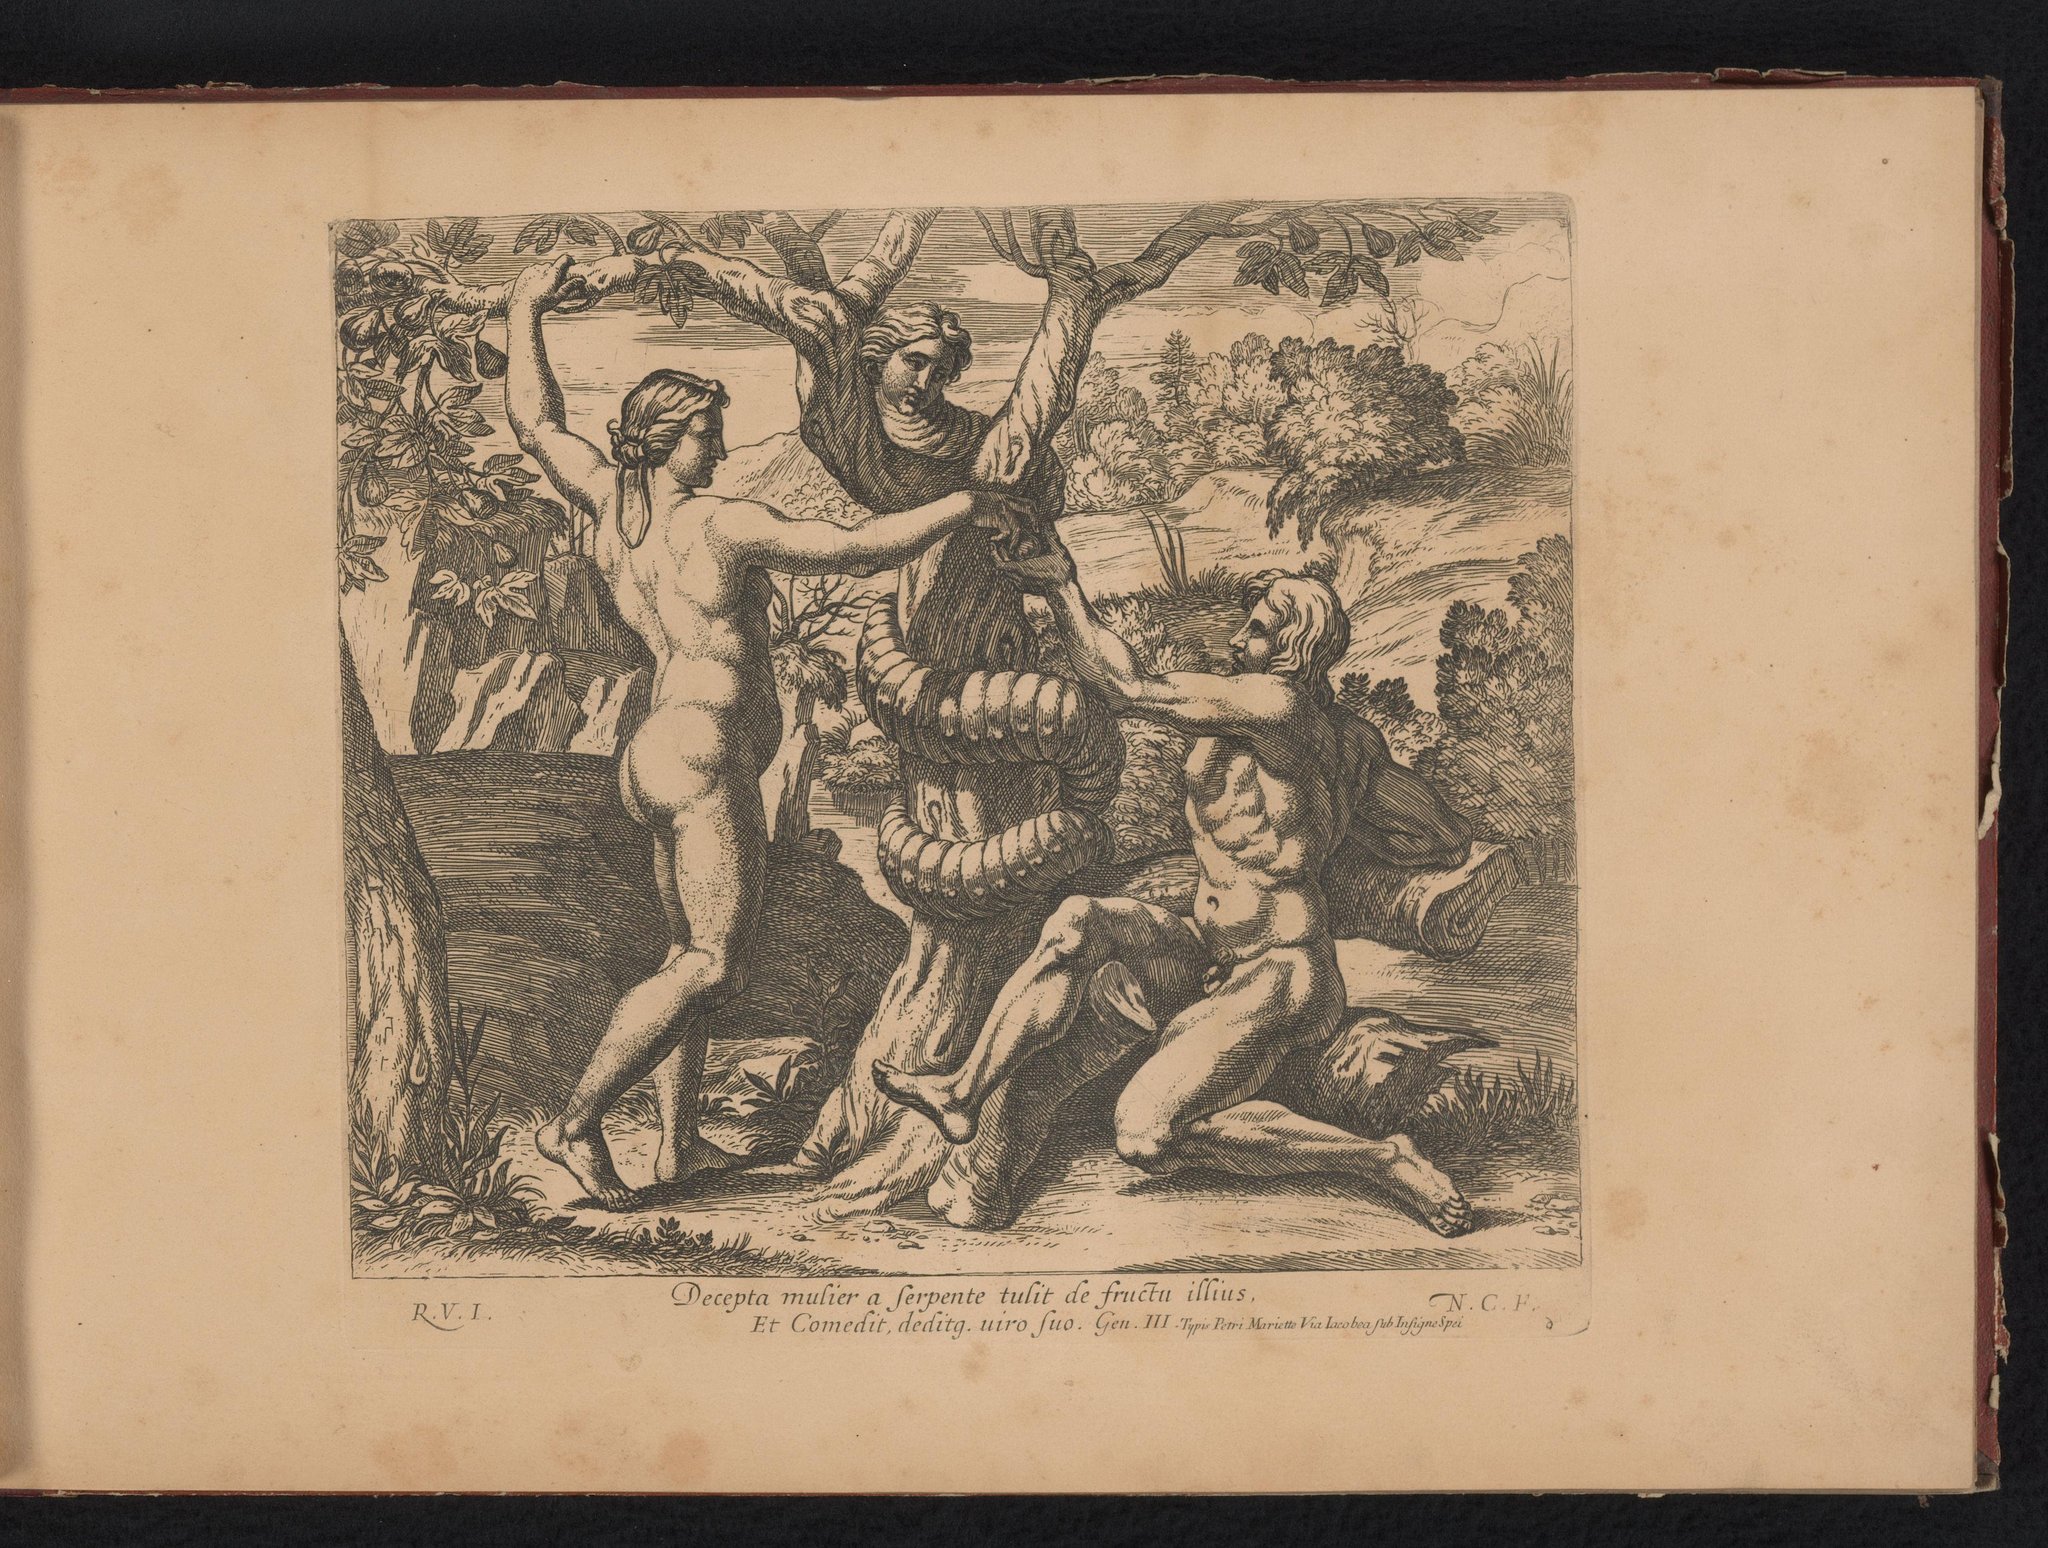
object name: album leaf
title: Rafaël Bijbel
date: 1649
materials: paper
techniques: etching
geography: paris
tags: creation of man; the garden of eden (genesis 1:26 - 2), god the creator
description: Deze prent maakt deel uit van een album.